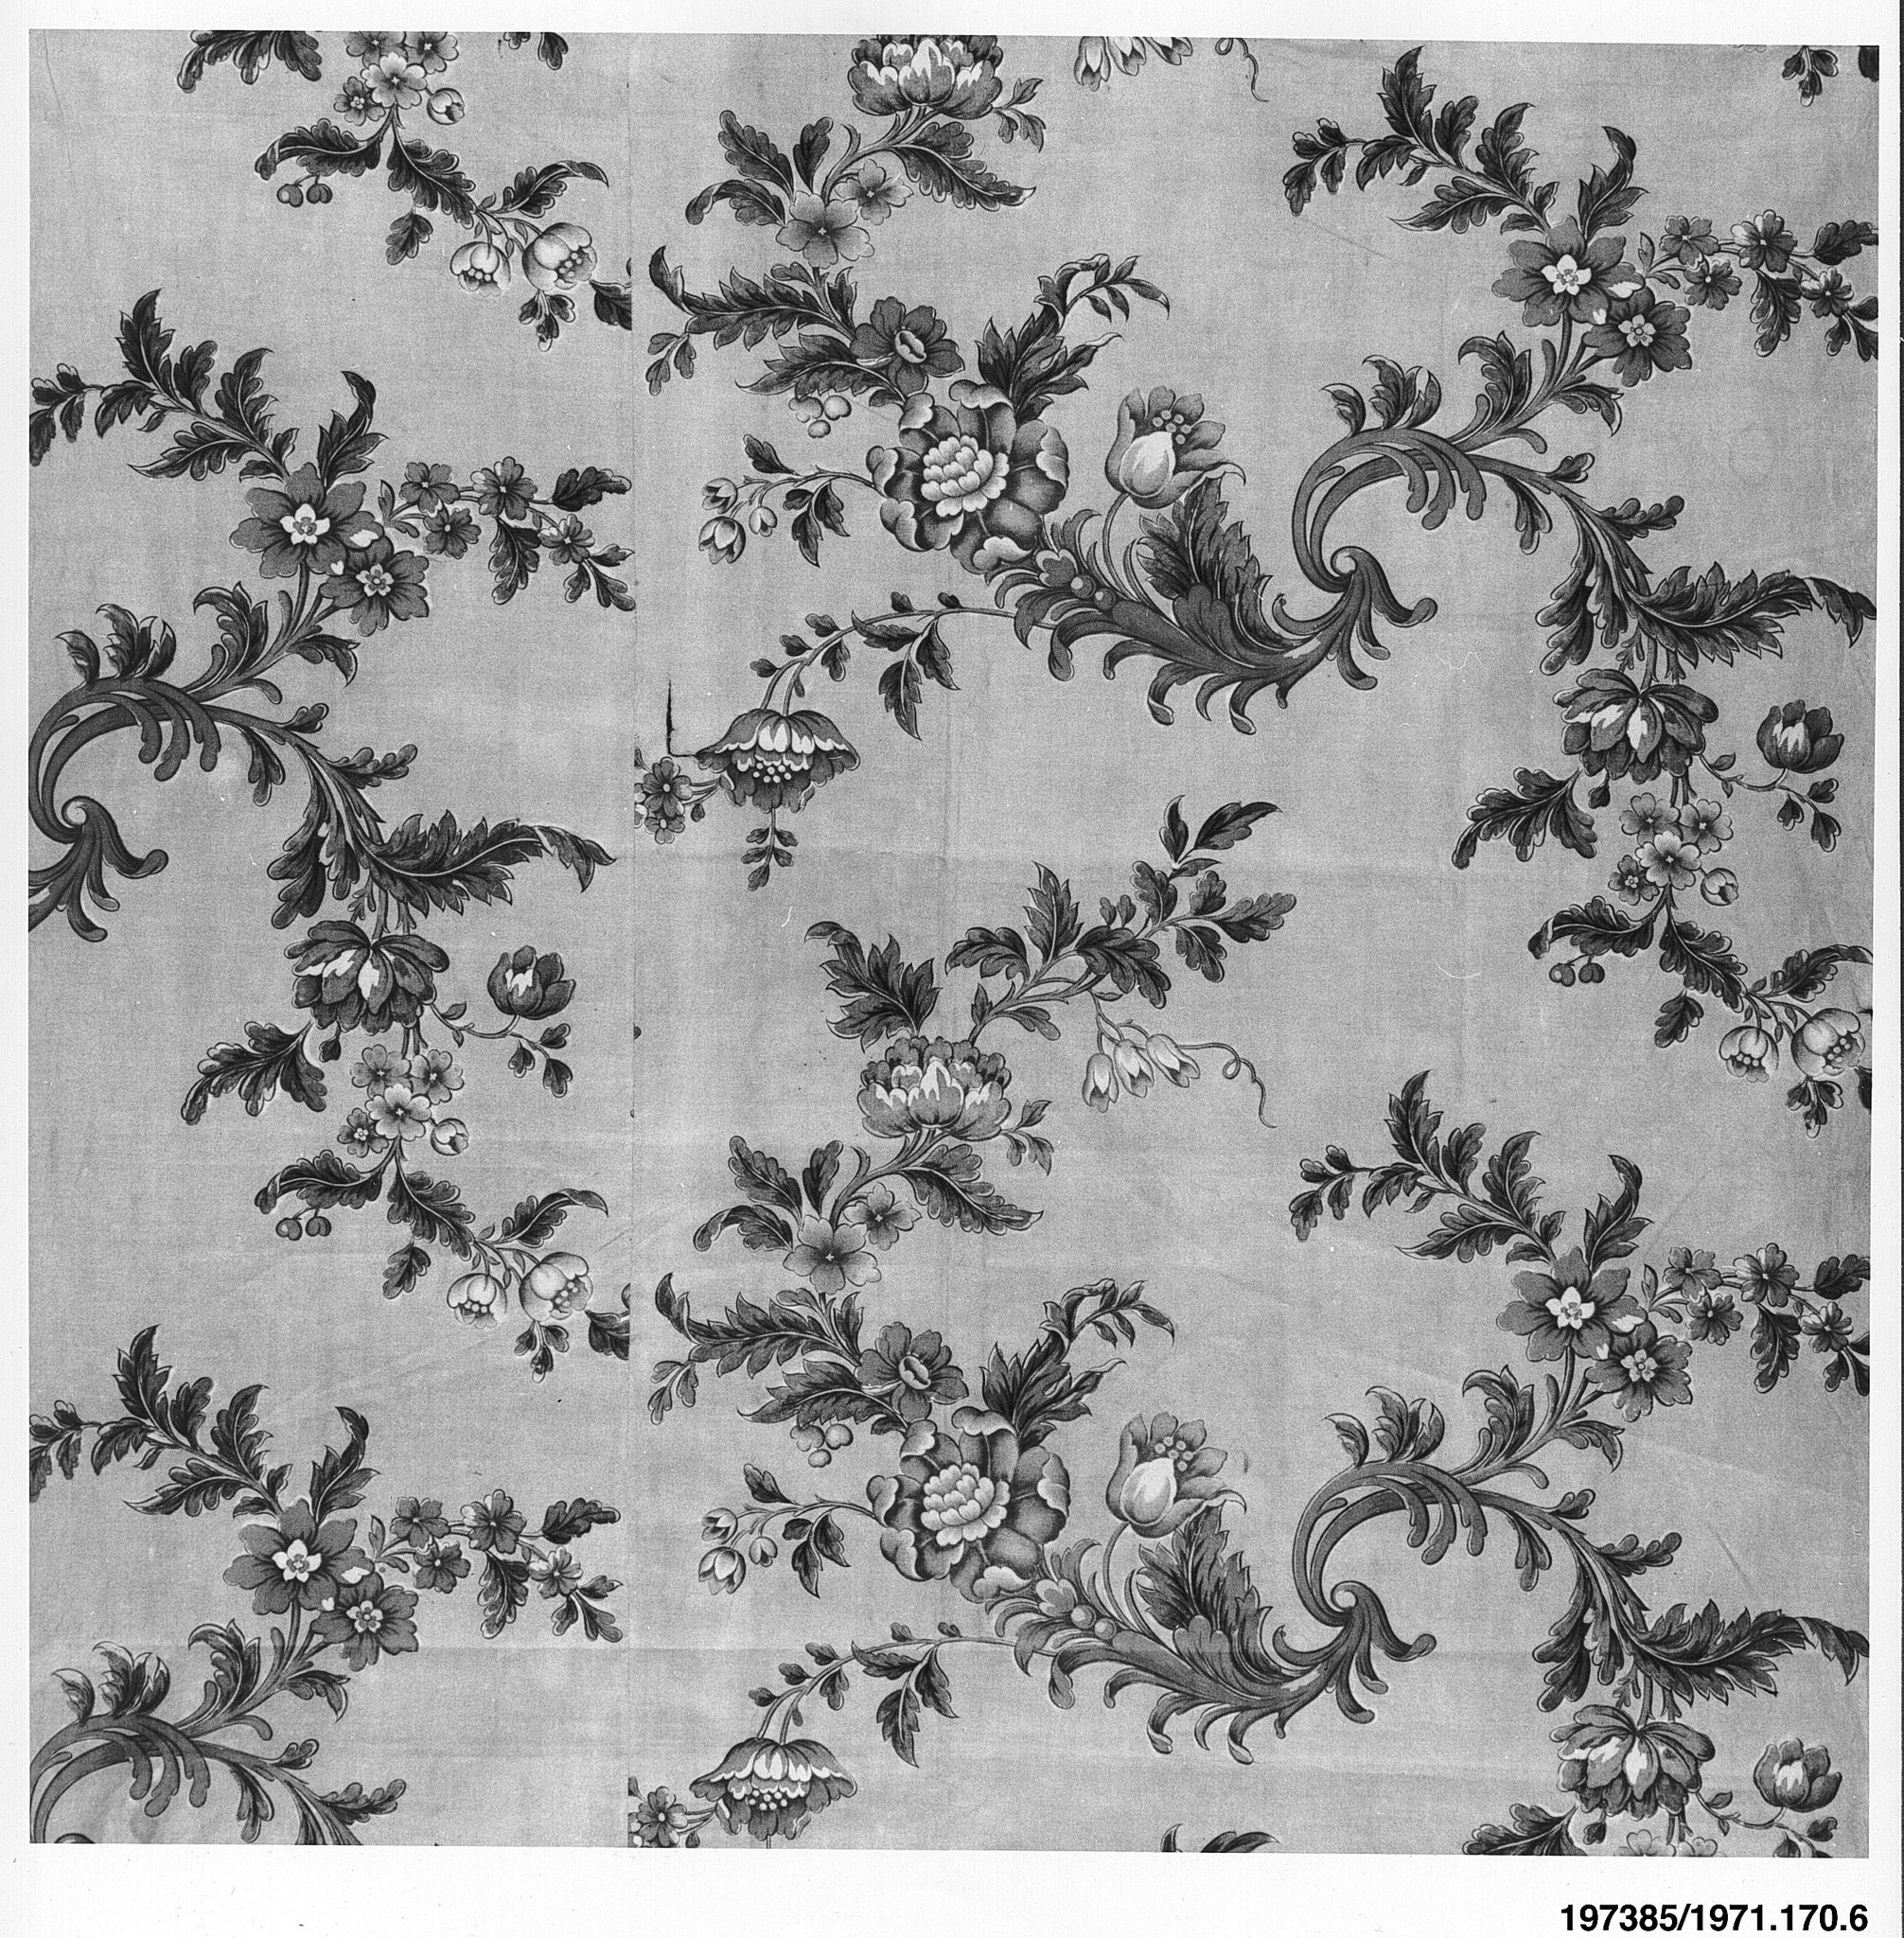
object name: piece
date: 1830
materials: cotton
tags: flowers,leaves